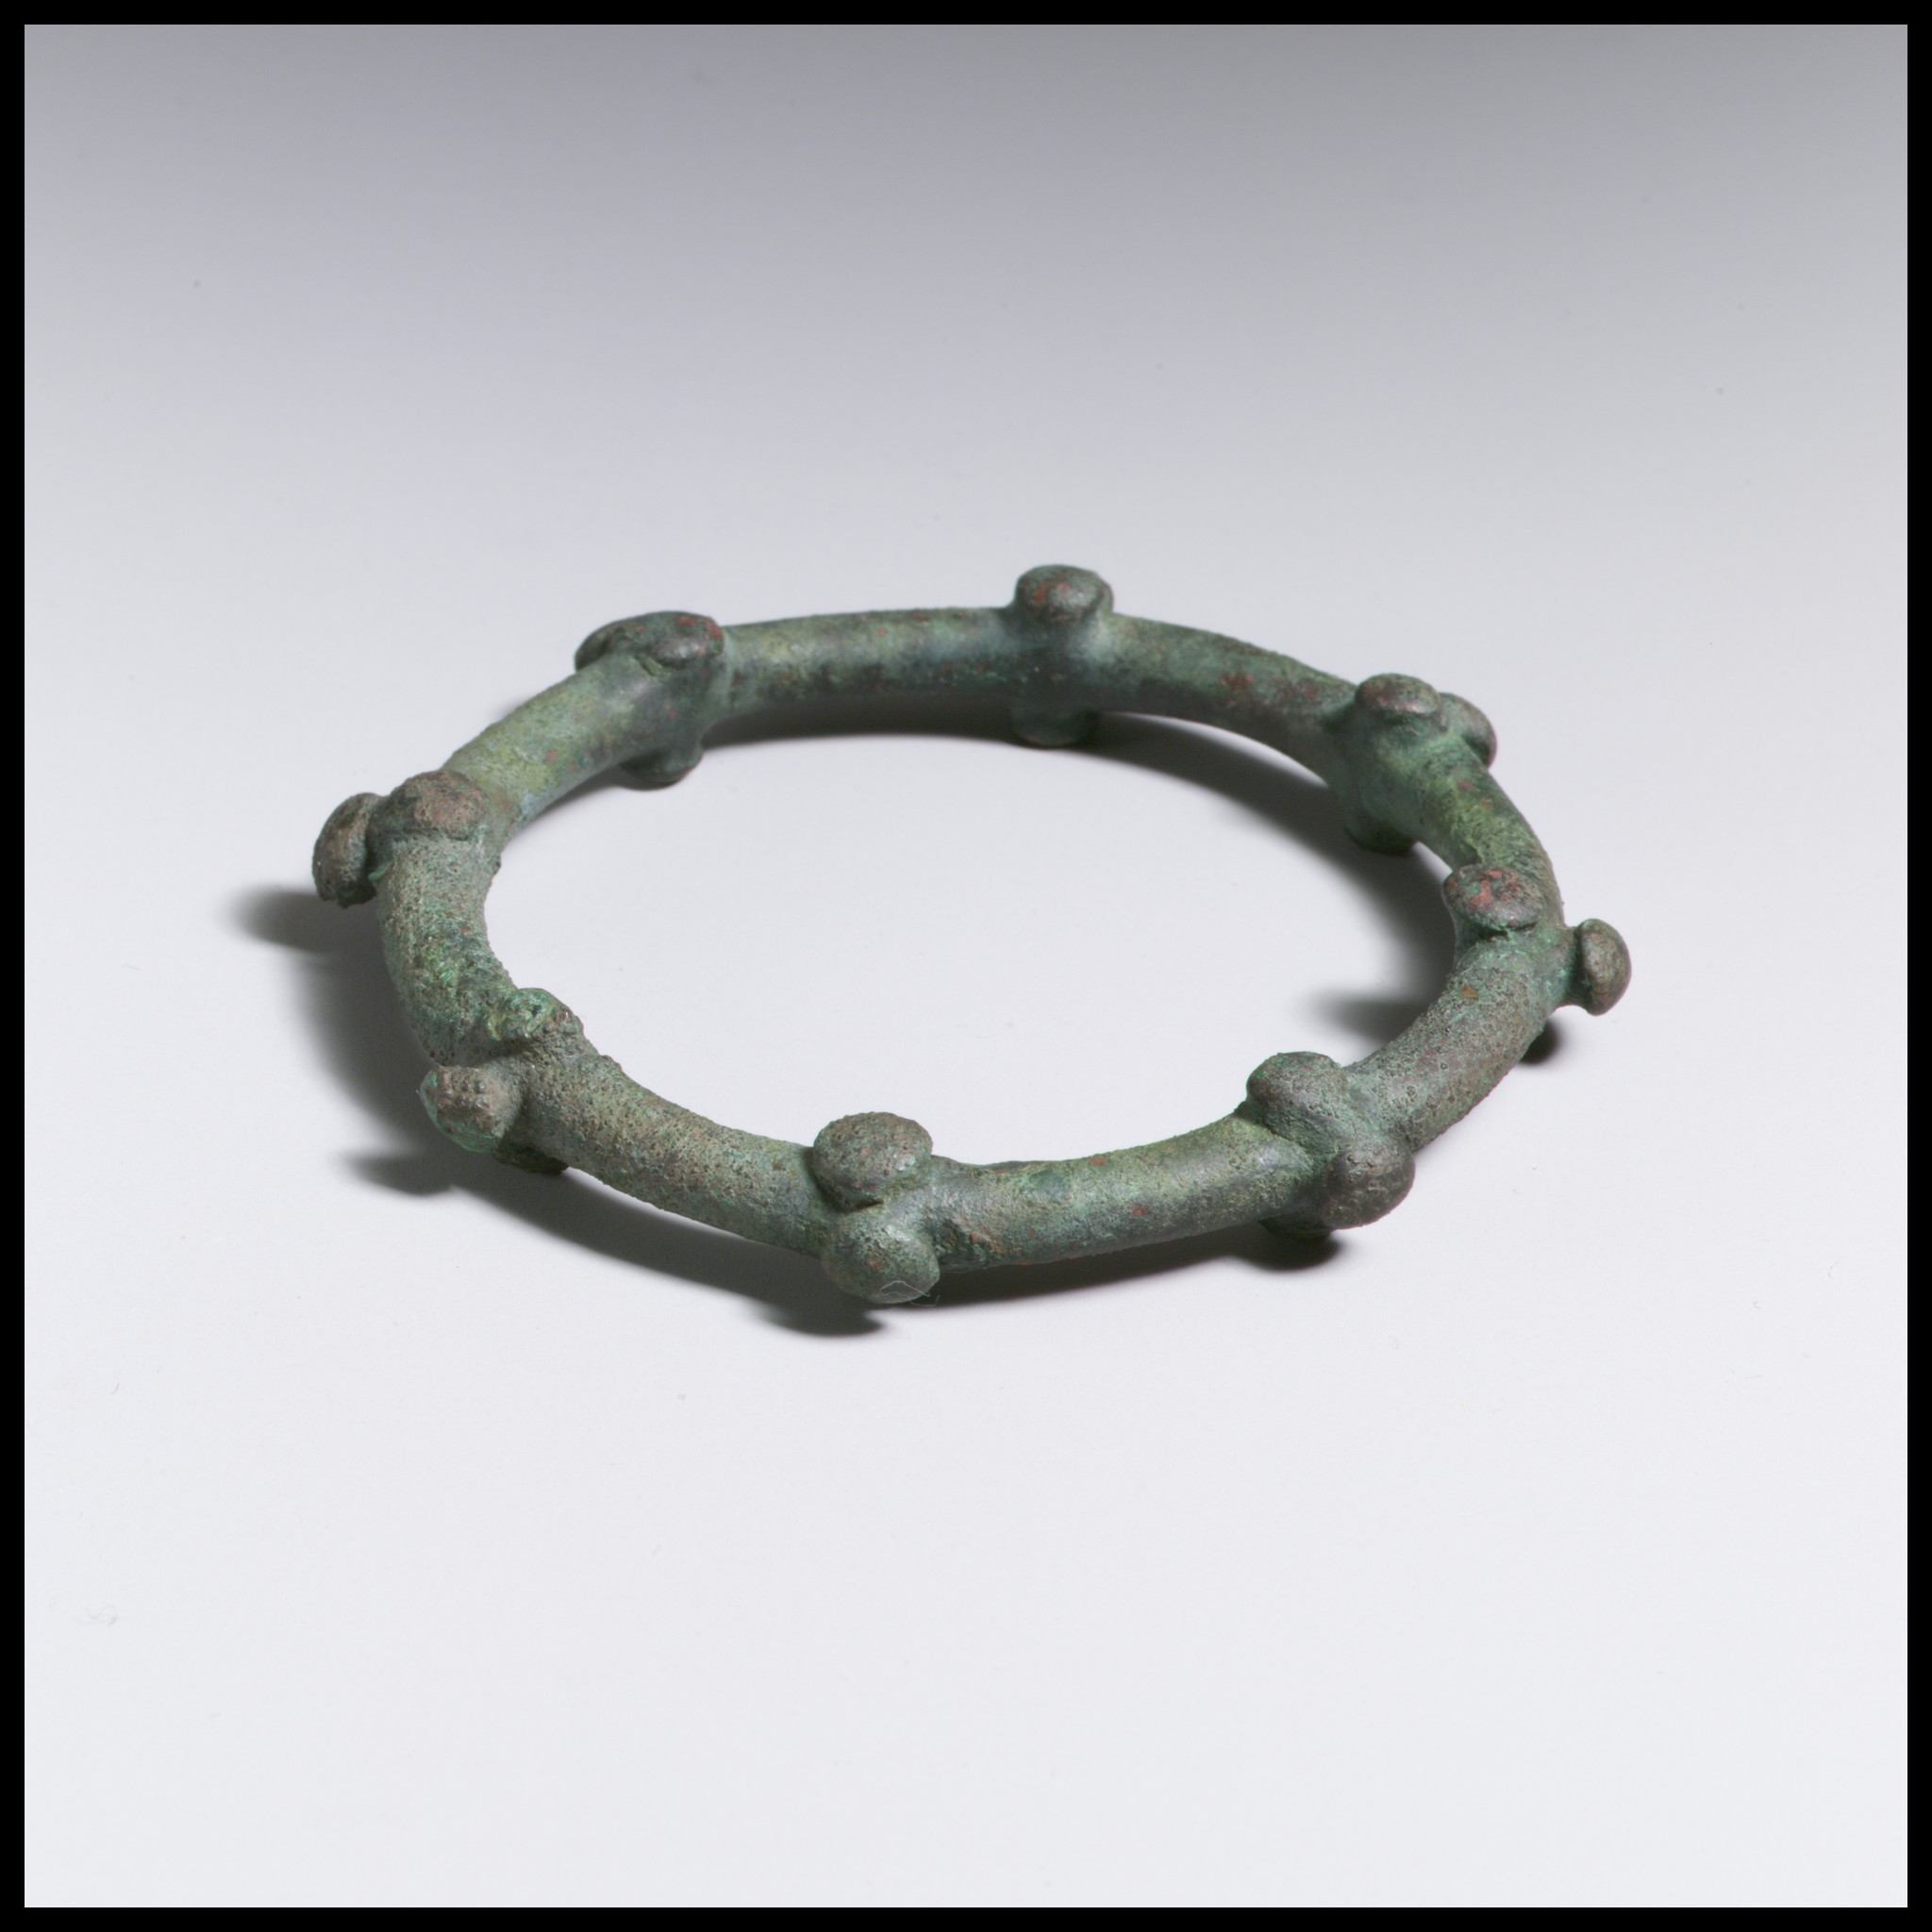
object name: bracelet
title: Bronze bracelet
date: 7000 BCE-330 CE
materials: bronze